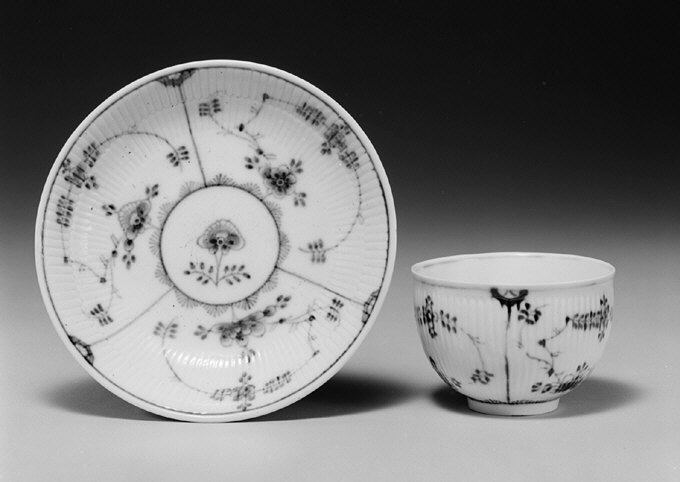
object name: teabowl and saucer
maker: frankenthal porcelain manufactory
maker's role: manufactory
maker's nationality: german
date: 1775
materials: hard paste porcelain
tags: flowers